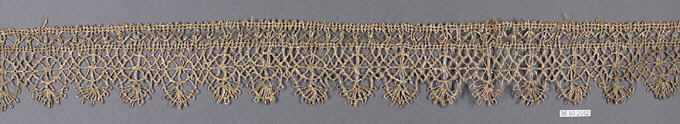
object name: piece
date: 1701-1800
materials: metal thread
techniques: lace